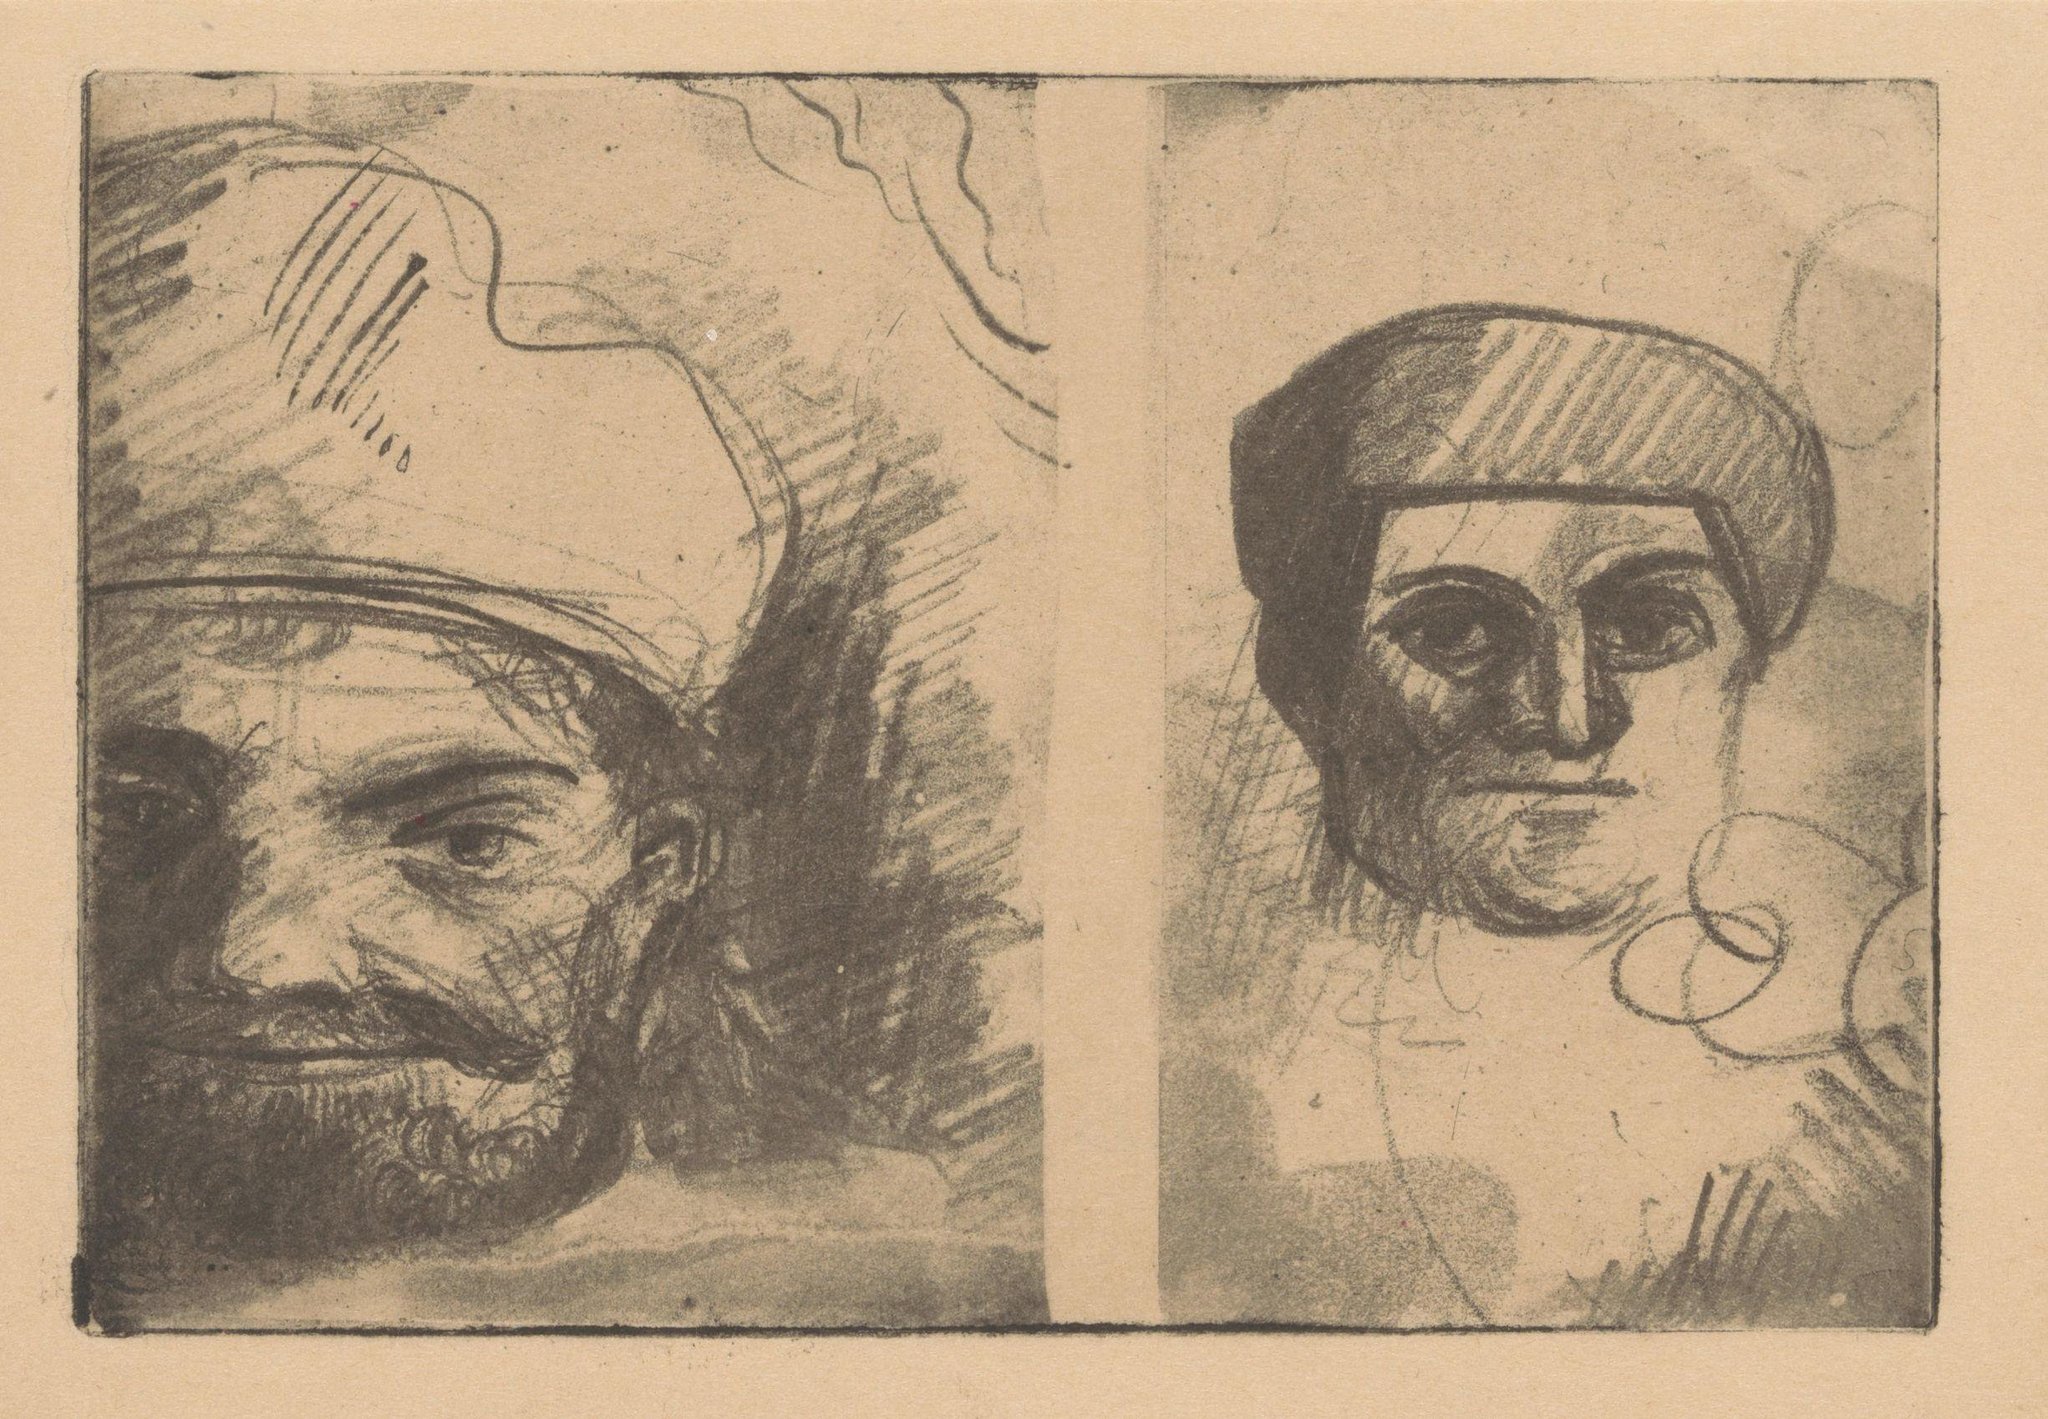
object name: print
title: Twee mannenhoofden met mutsen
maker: marius holleman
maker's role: draughtsman, print maker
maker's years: 1878-1926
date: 1904-1926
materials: paper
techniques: etching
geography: groningen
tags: head-gear, adult man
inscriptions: collector's mark: Lugt 2228